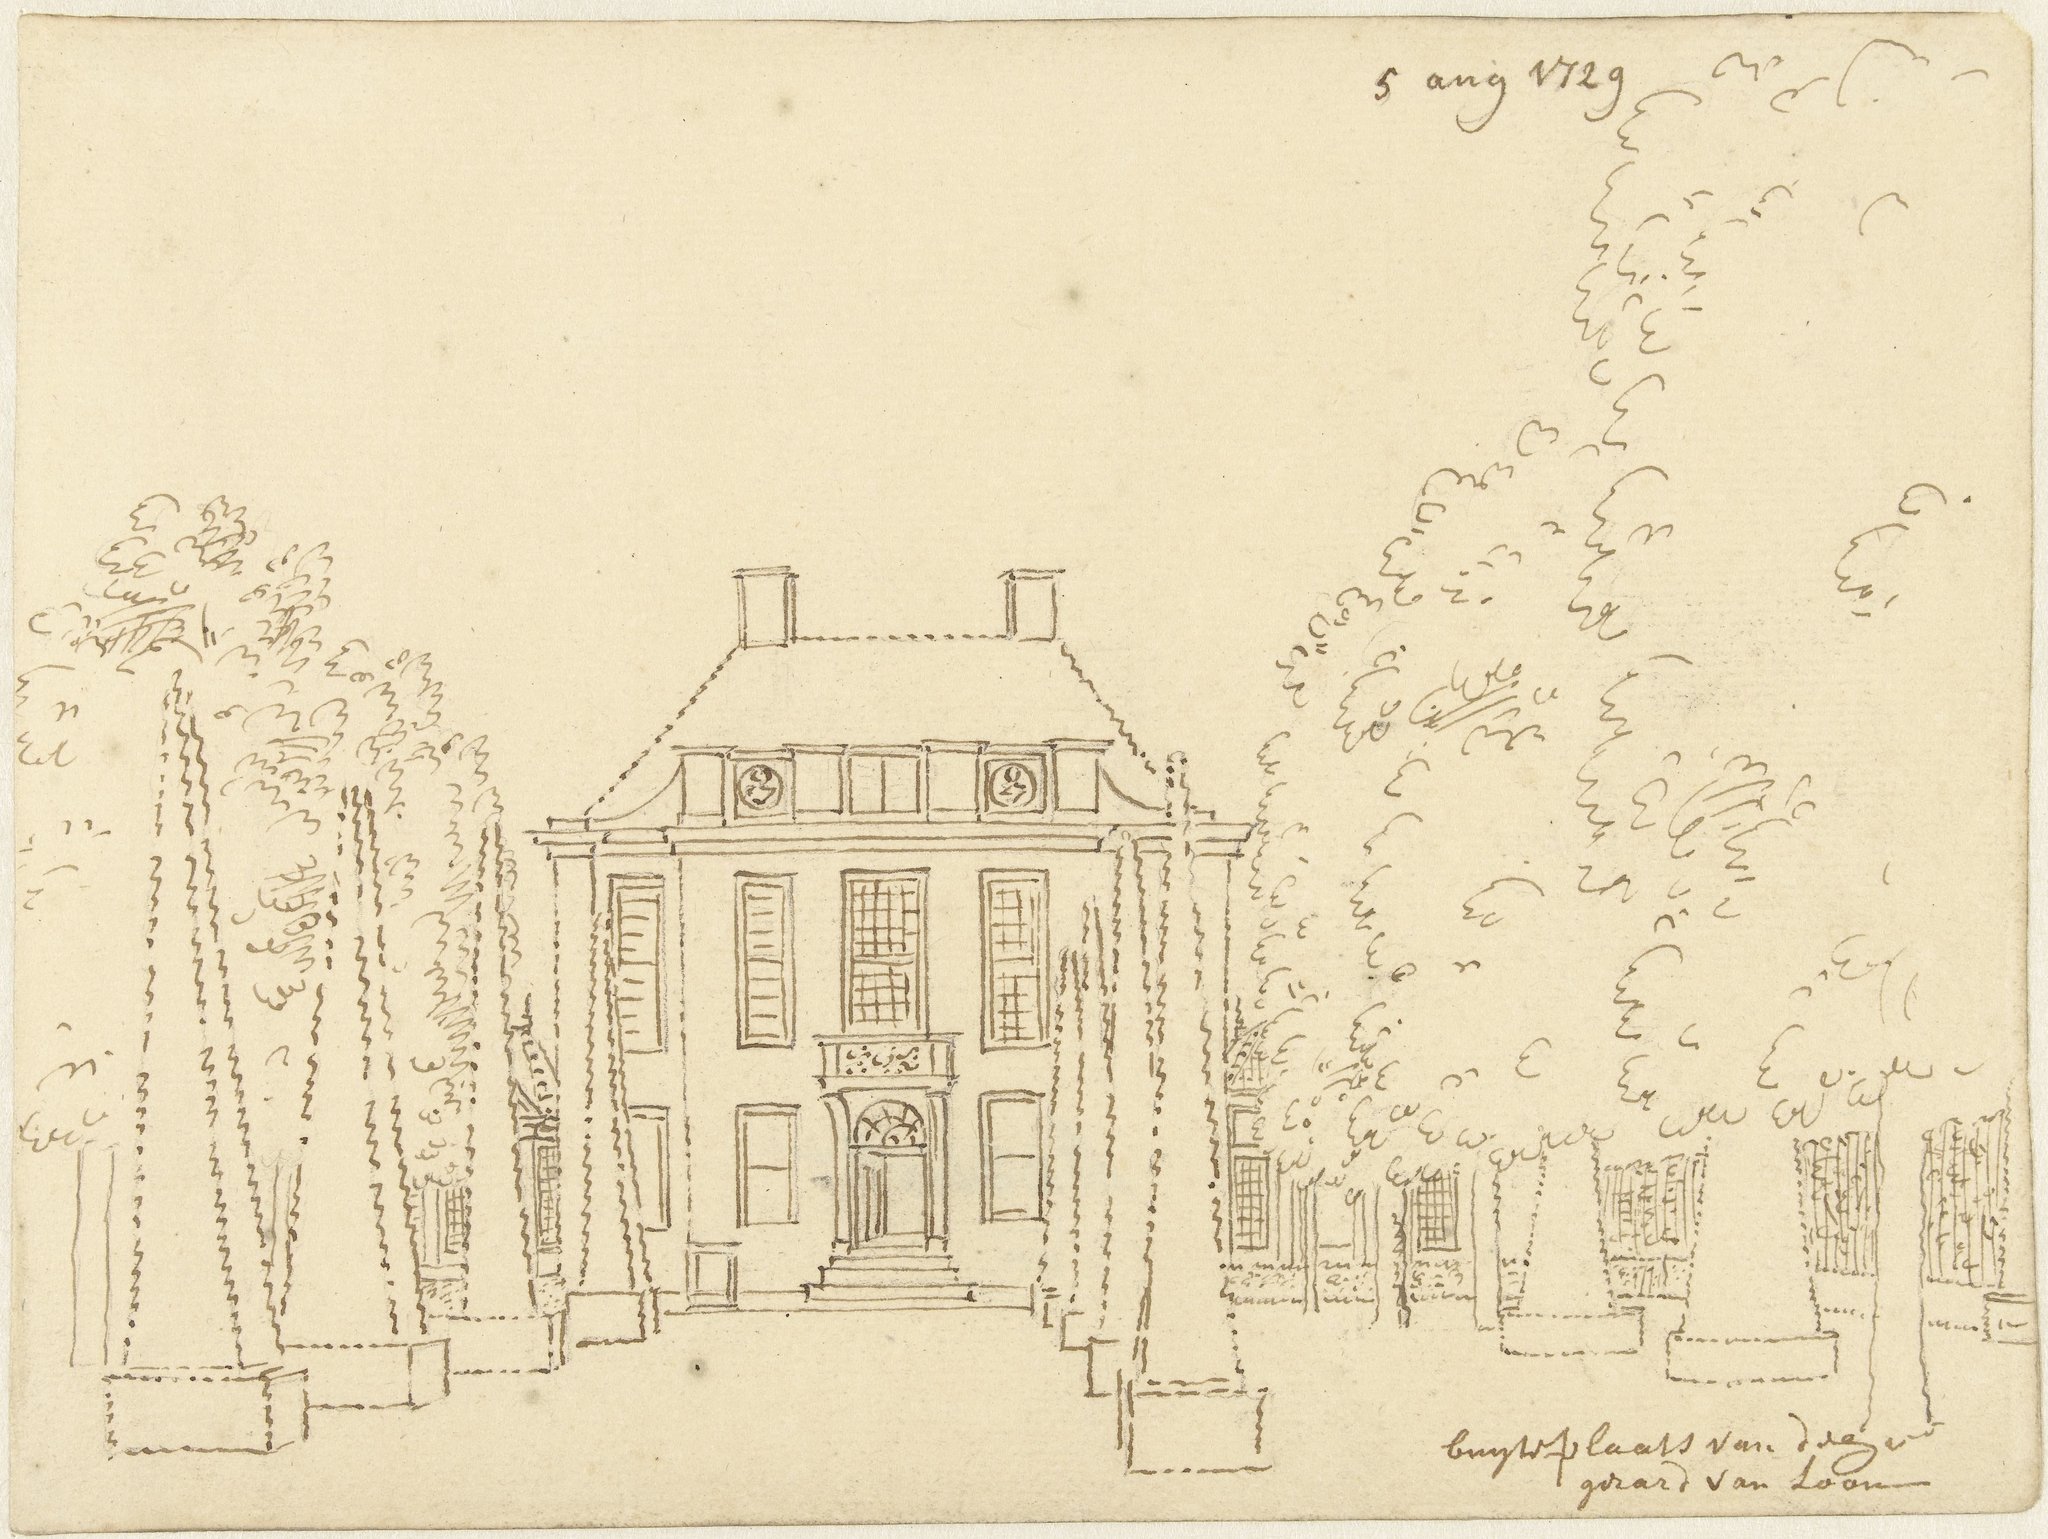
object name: drawing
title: Buitenplaats van Gerard van Loon; vooraanzicht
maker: cornelis pronk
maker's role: draughtsman, painter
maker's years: 1691-1759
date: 1729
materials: ink, paper, pencil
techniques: pen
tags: designer, gerard van loon, castle, rural housing, e.g. country-house, villa, cottage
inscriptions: inscription: ‘buytenplaats van de hr / gerard van loon’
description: De buitenplaats van Gerard van Loon aan de Oudedijk te Kralingen.